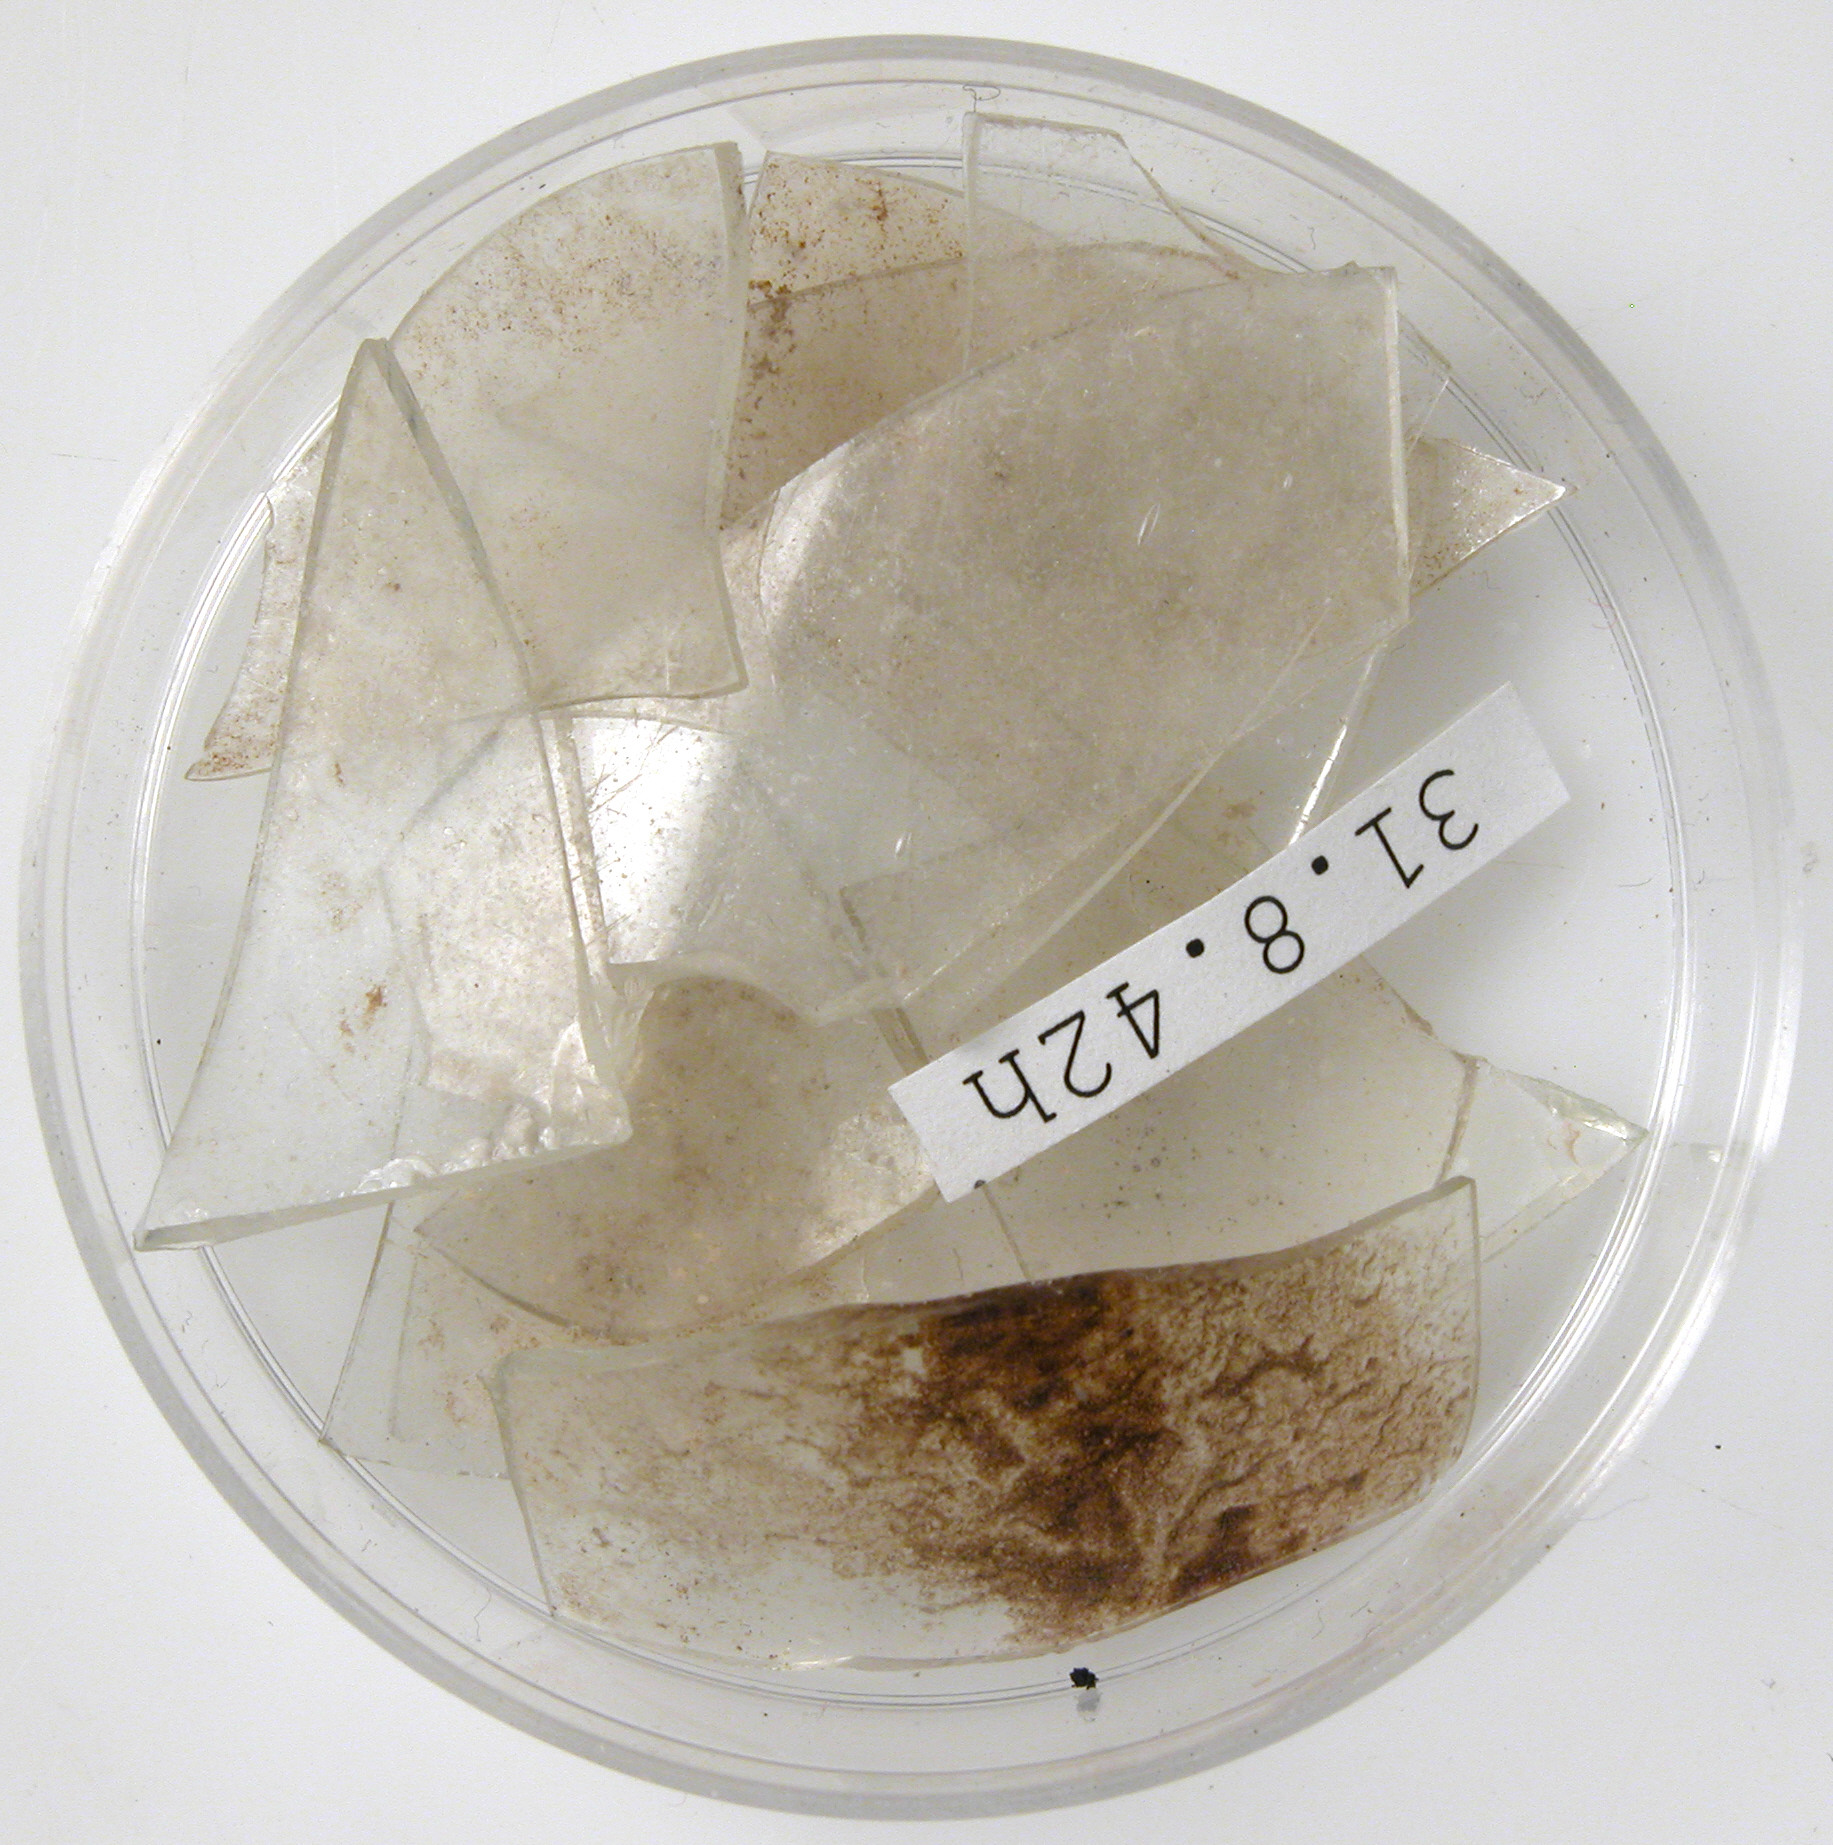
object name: fragment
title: Glass Fragments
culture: coptic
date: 301-400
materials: glass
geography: egypt